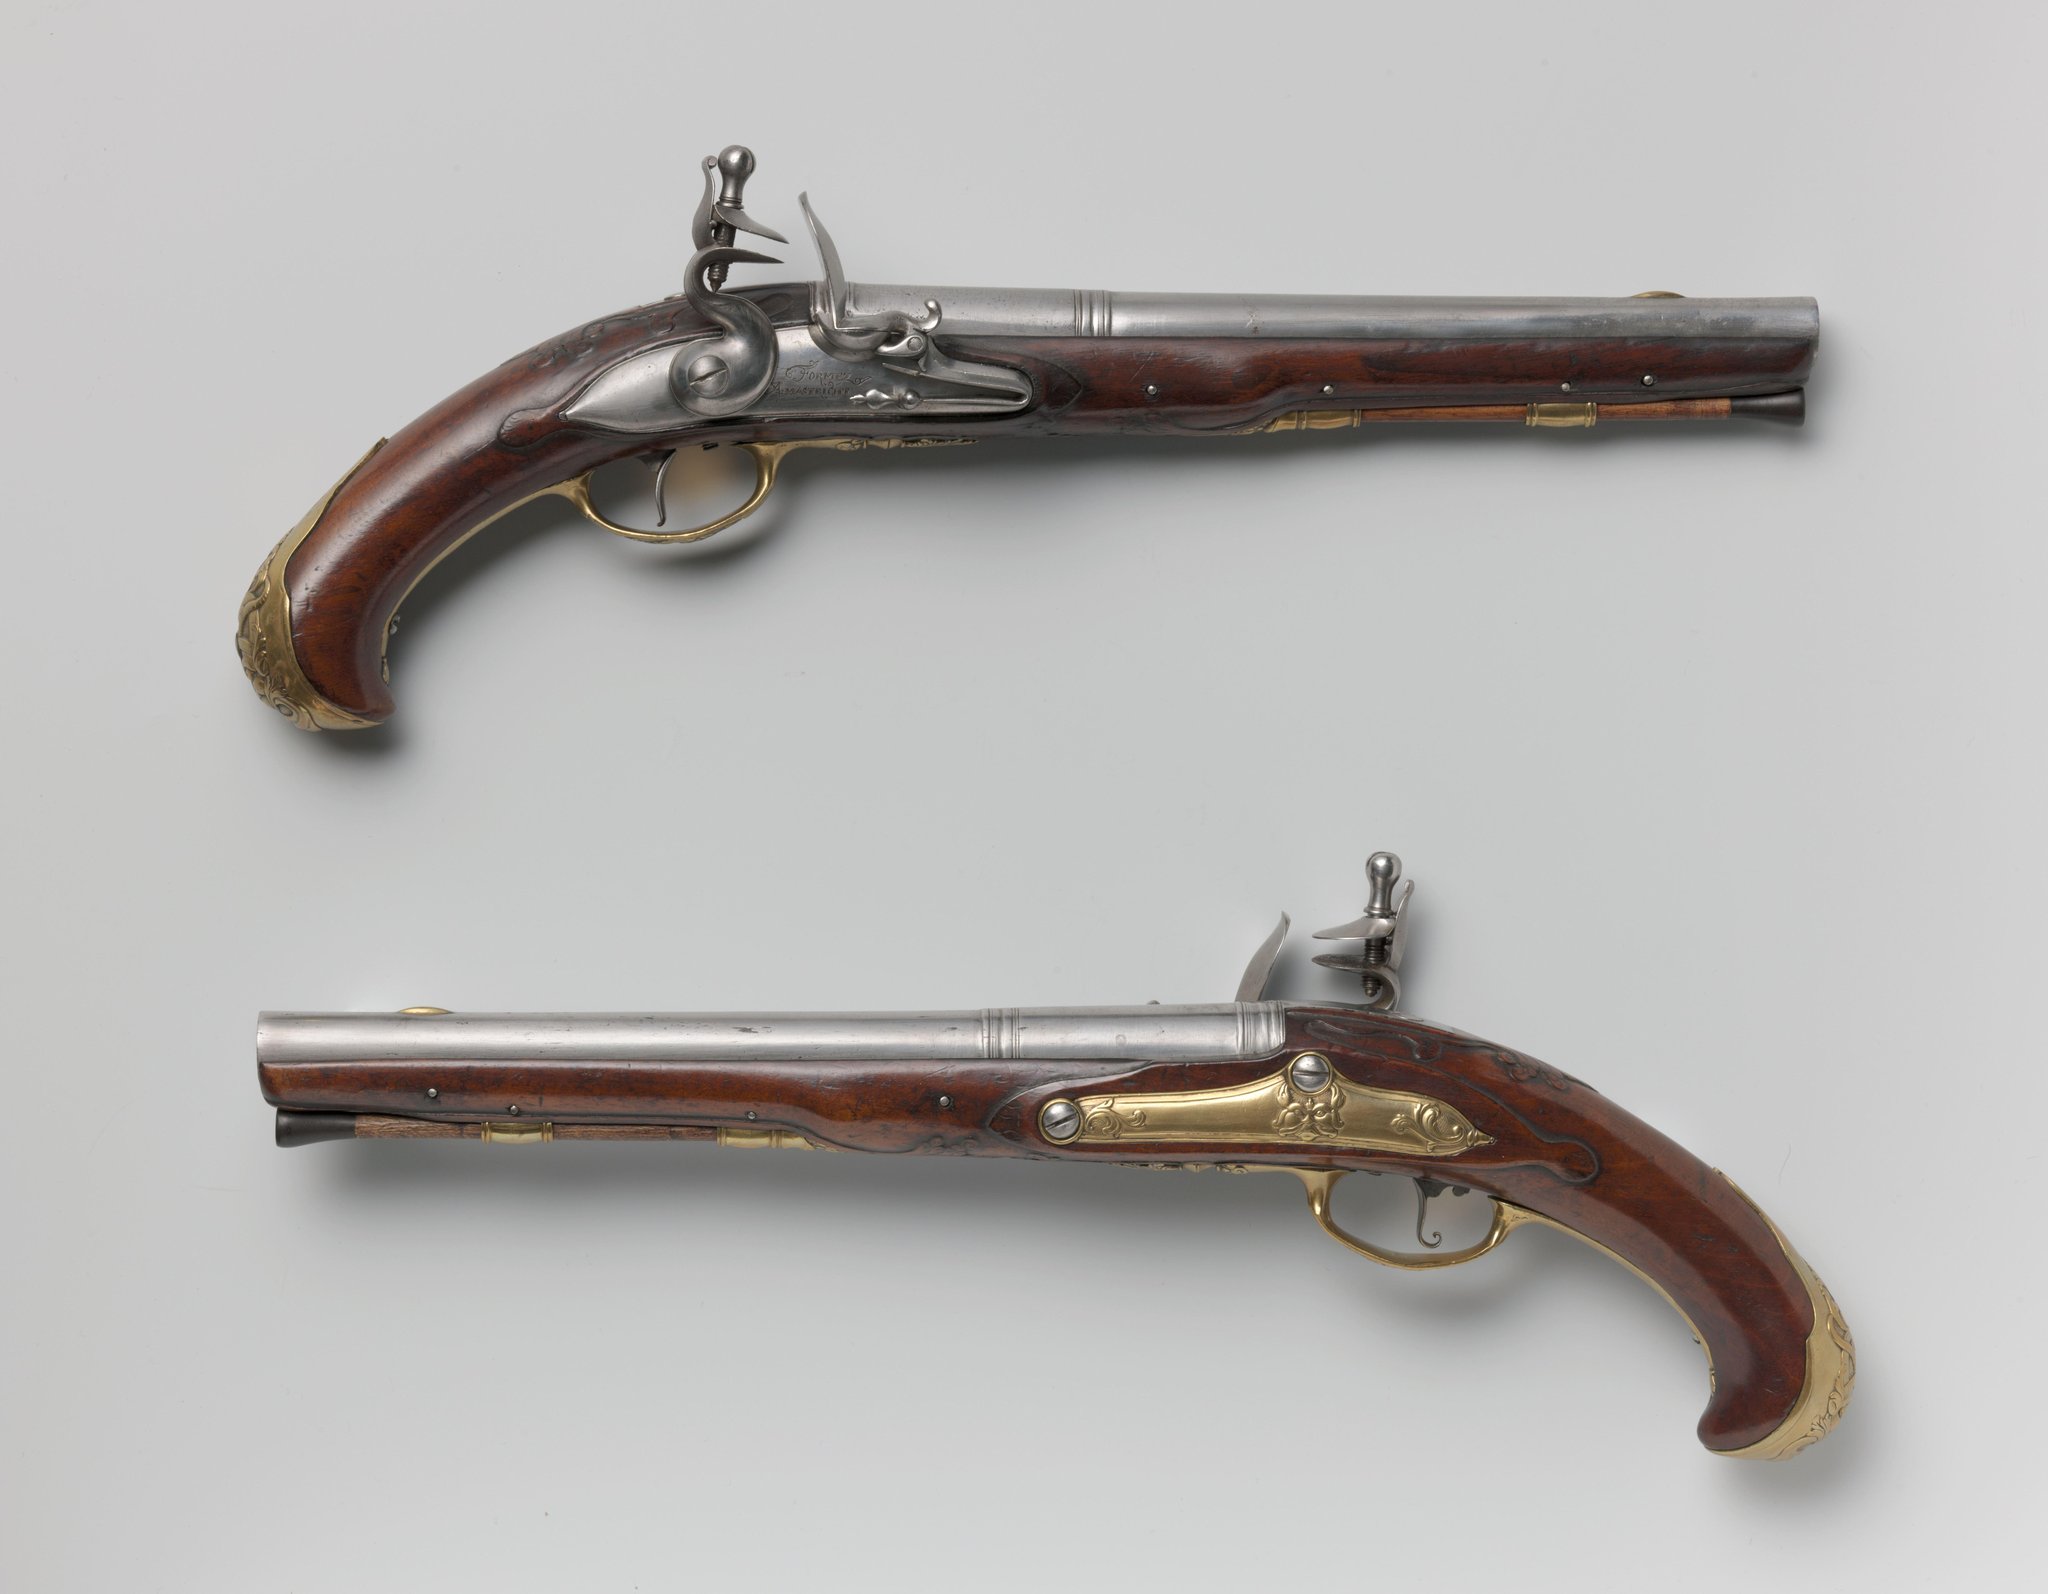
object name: flintlock pistol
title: Vuursteenpistool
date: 1770-1780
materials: brass, iron, wood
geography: maastricht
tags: netherlands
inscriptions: mark: ‘Formez, Mastricht’, mark: ‘B.F.’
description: Pistool met vuursteenslot, deel van koppel. Ronde loop. Een paar banden in reliëfwerk. Messing vizierkorrel, geen keep. Ronde slotplaat waarop: Formez, Mastricht. Lade enigszins bewerkt. Messing beslag. Zilveren reliëfversiering. Op de loop de letters F.M.[?]. Op de keep gemerkt B.F. [eigenaar].